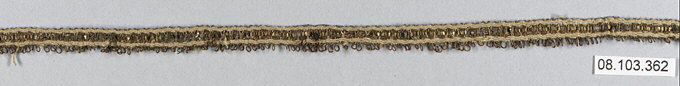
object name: galloon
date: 1501-1600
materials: cotton, metal thread